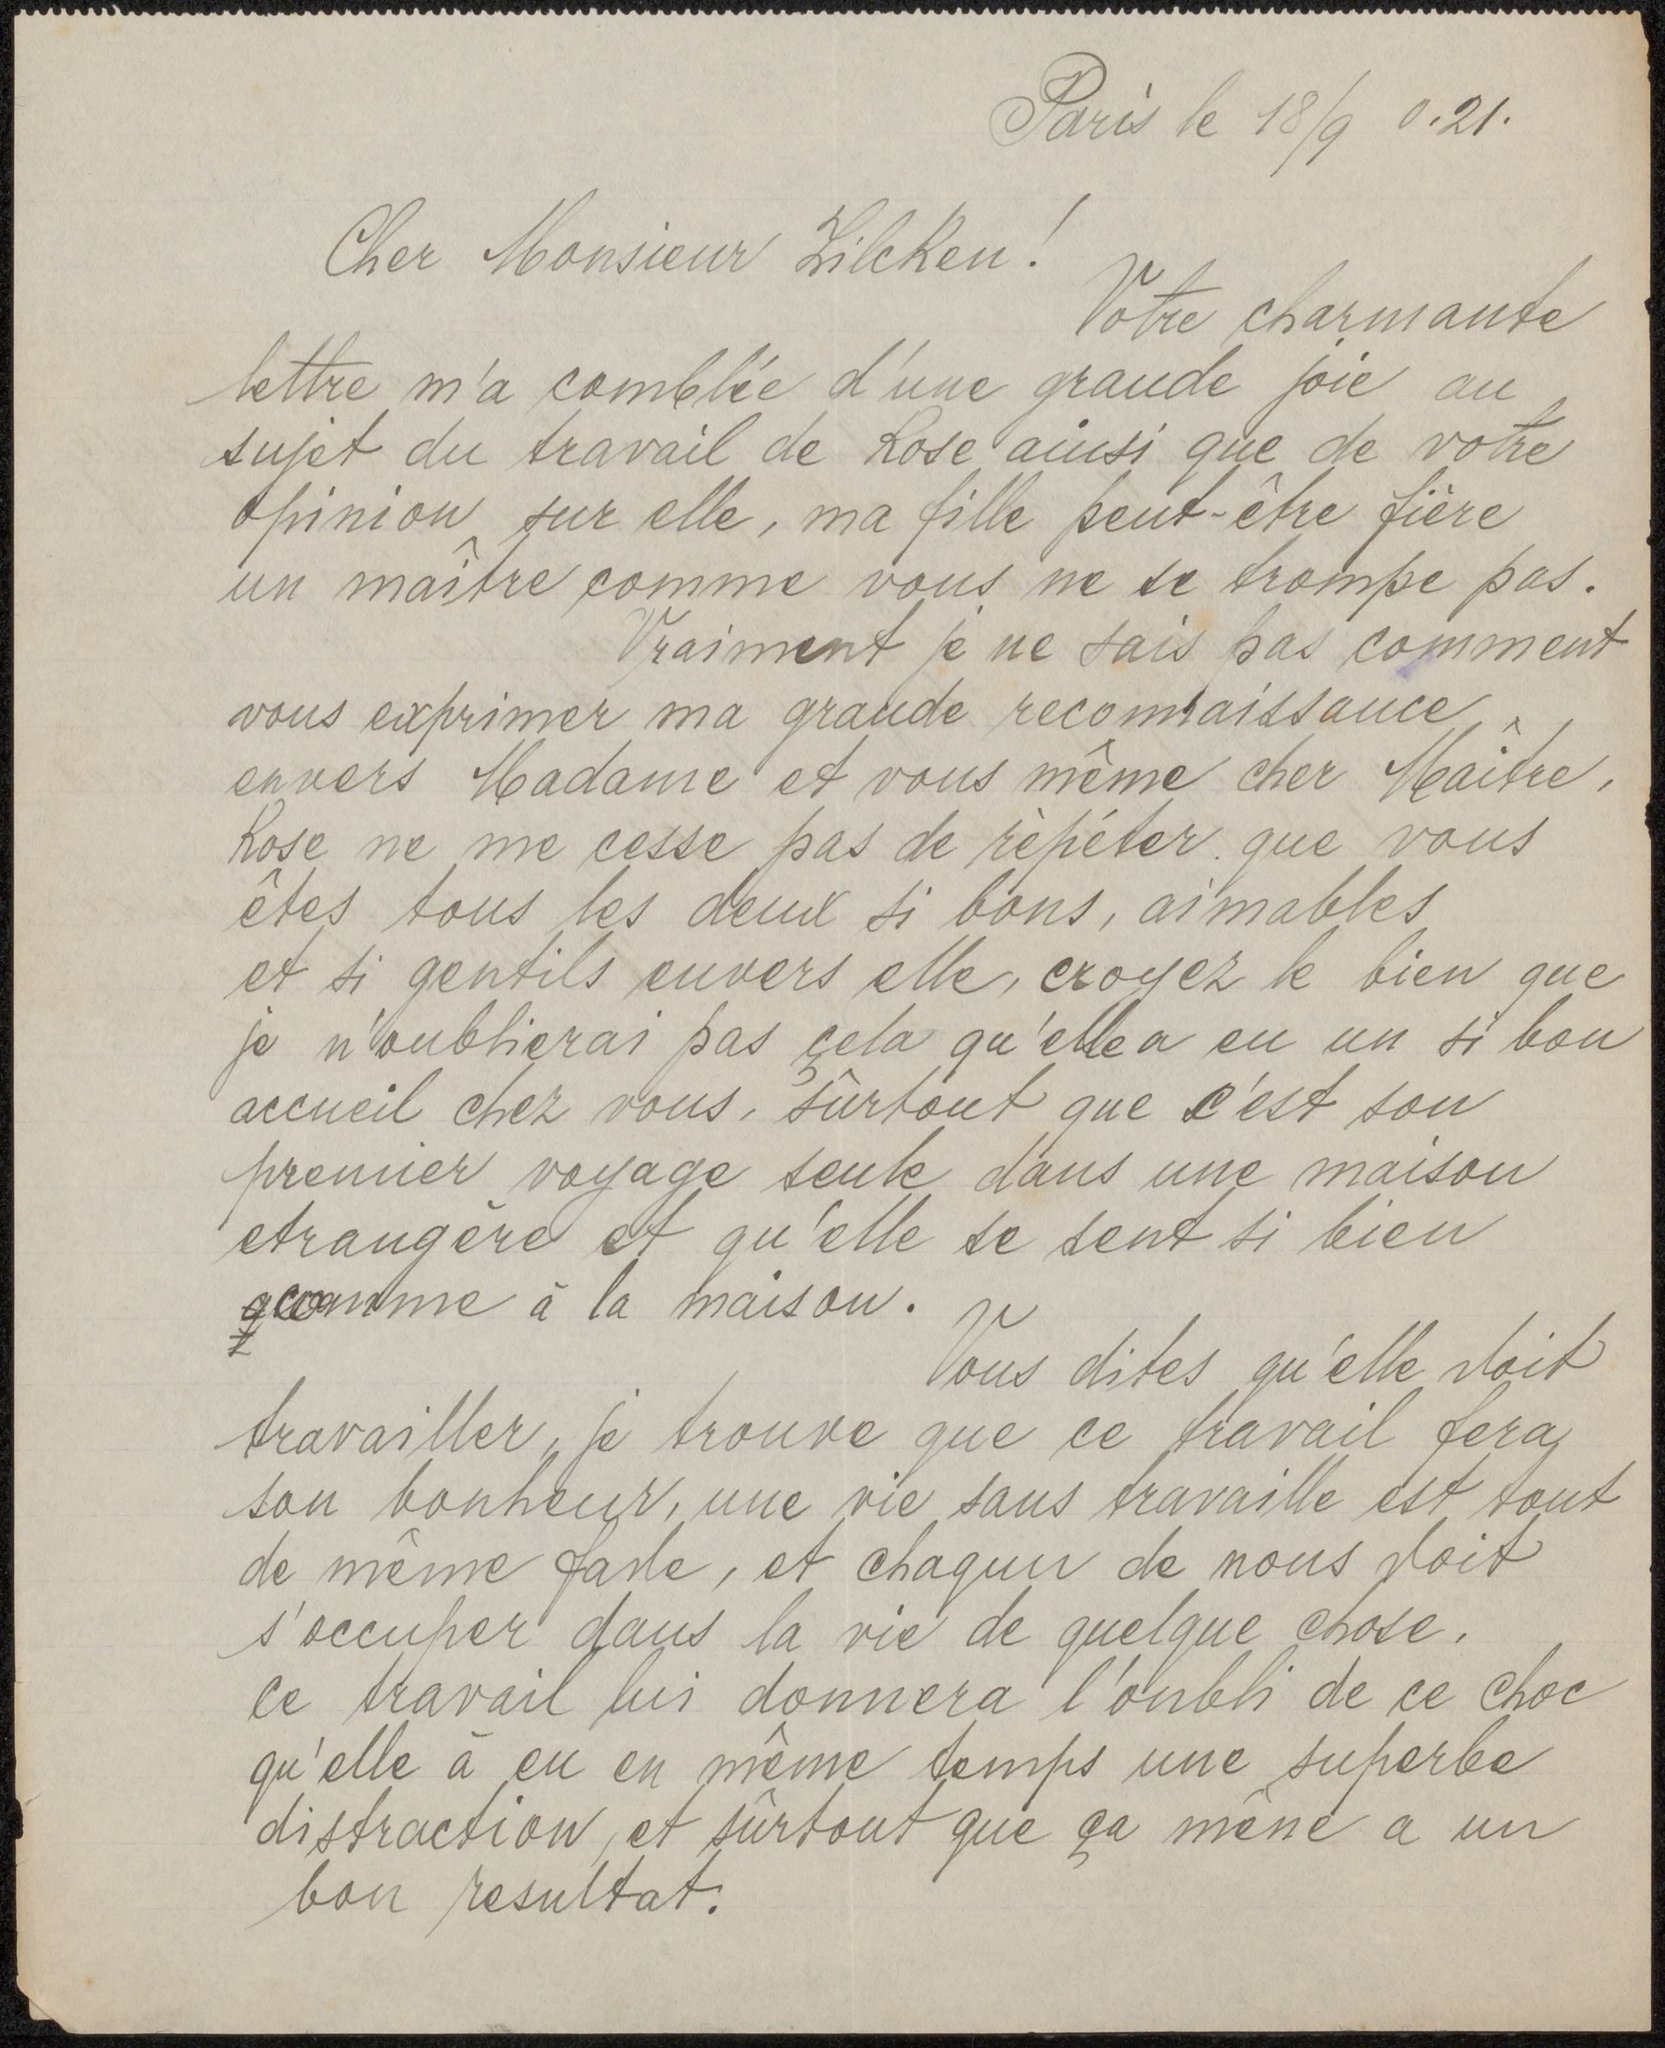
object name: letter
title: Brief aan Philip Zilcken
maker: t. himelschein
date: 1921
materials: ink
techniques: pen, writing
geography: paris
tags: rose imel, the hague, painter, philip zilcken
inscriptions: collector's mark: ‘RPK’